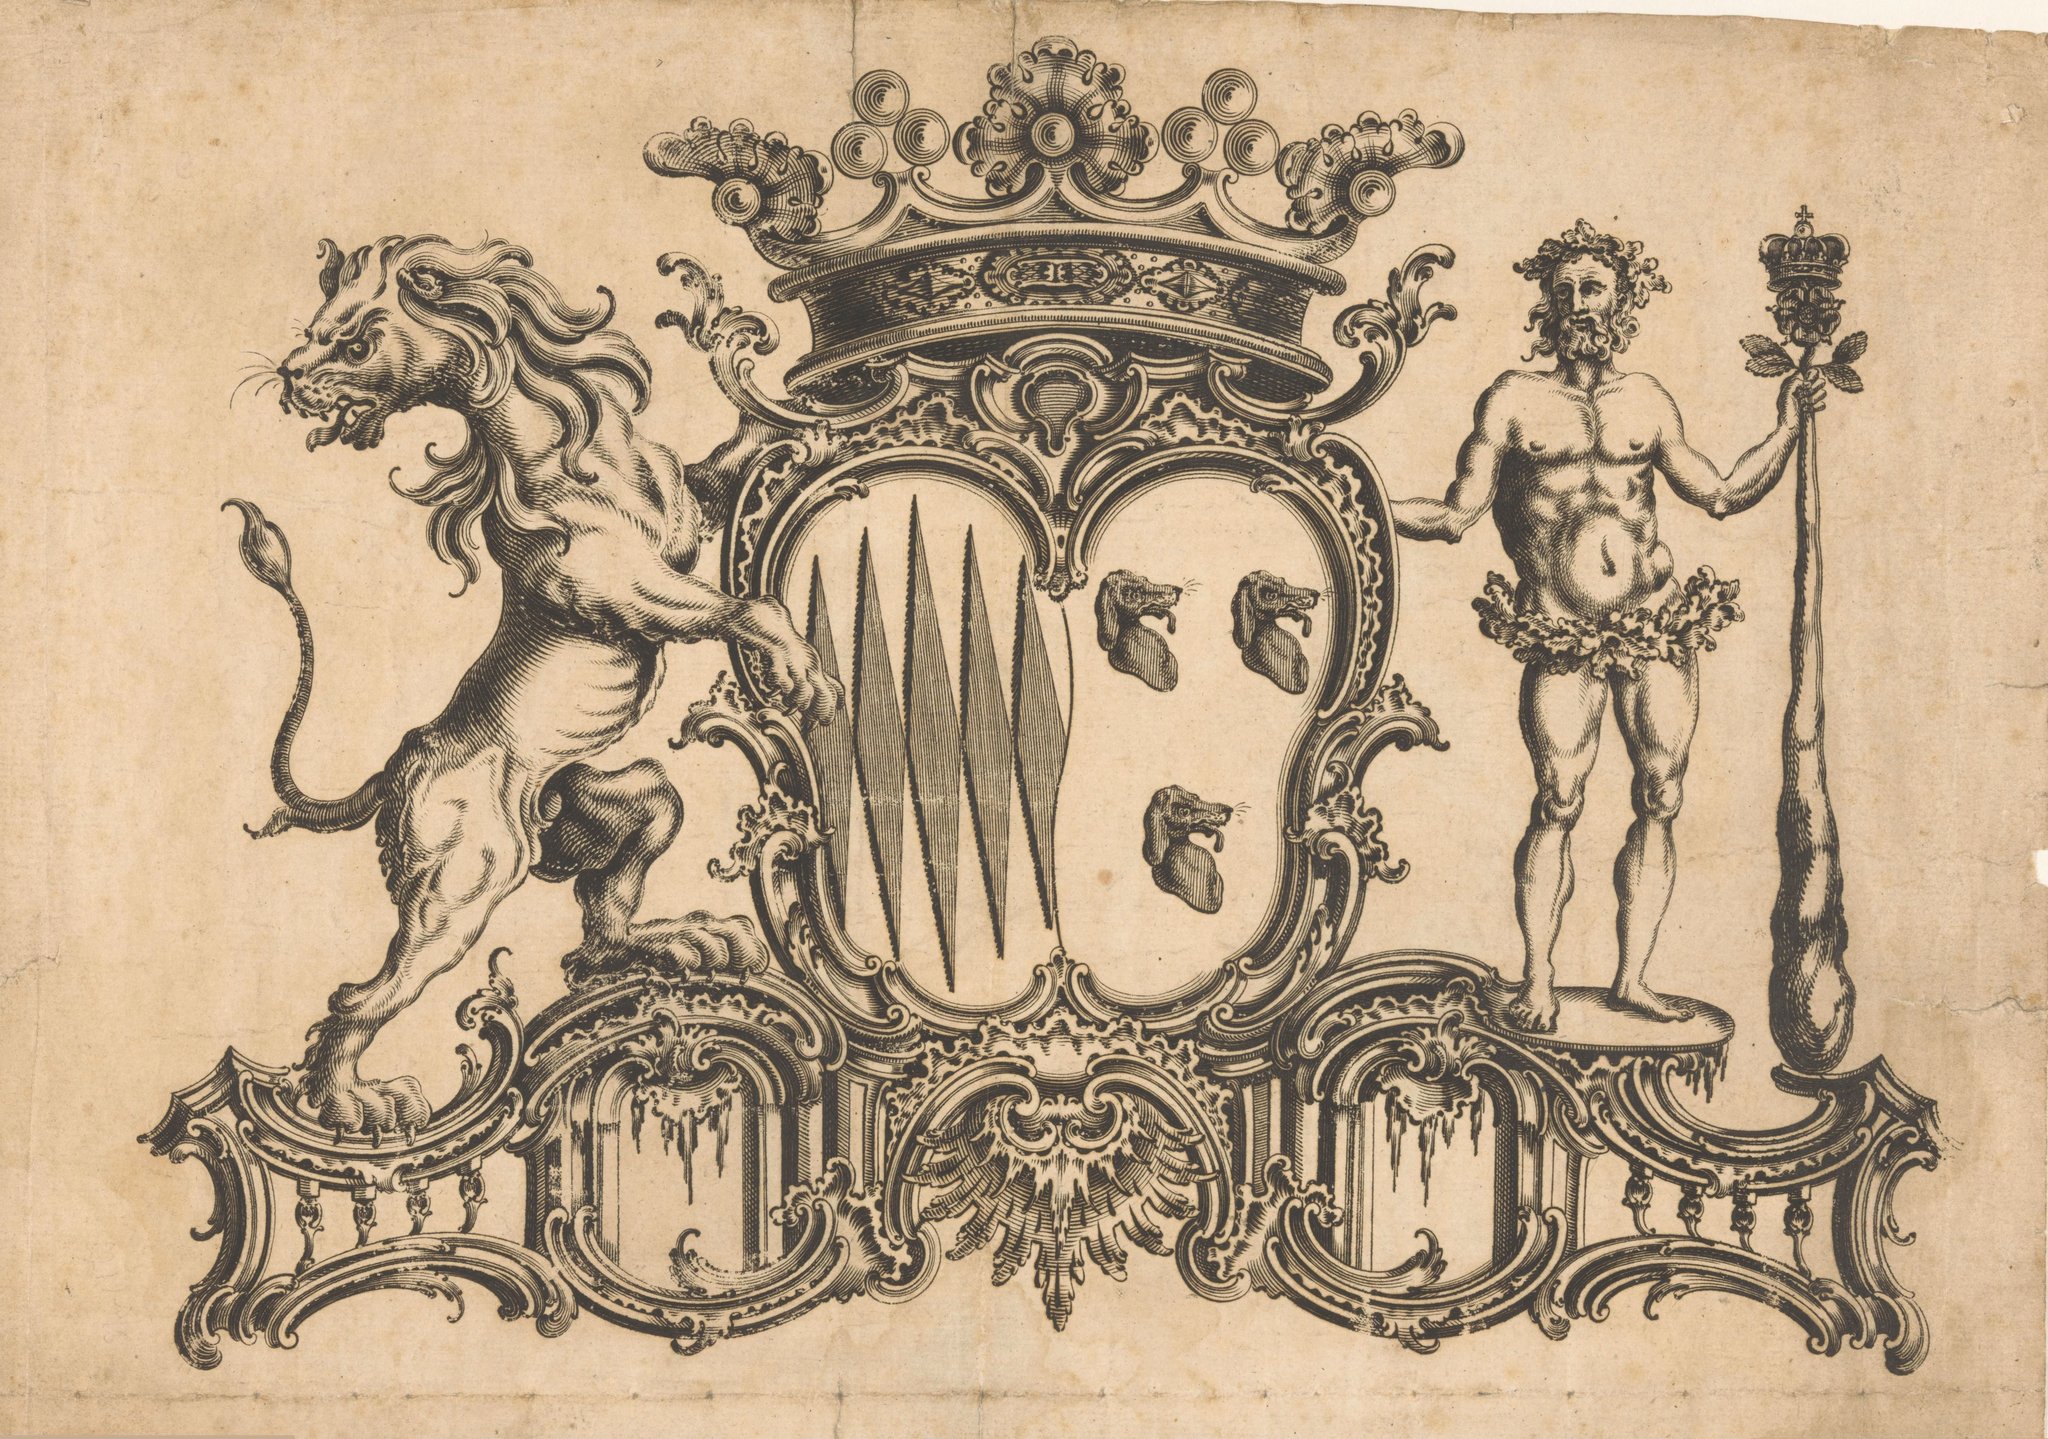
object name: print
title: Wapen geflankeerd door leeuw en Hercules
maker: Anonymous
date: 1740-1760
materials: paper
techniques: engraving, etching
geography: england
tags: coat of arms (symbol of sovereignty), (story of) hercules (heracles), beasts of prey, predatory animals: lion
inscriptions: collector's mark: Lugt 2228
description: Een gekroond wapenschild met rechts drie. Een brullende leeuw en Hercules met knots flankeren het schild, staand op rocaille ornamenten.